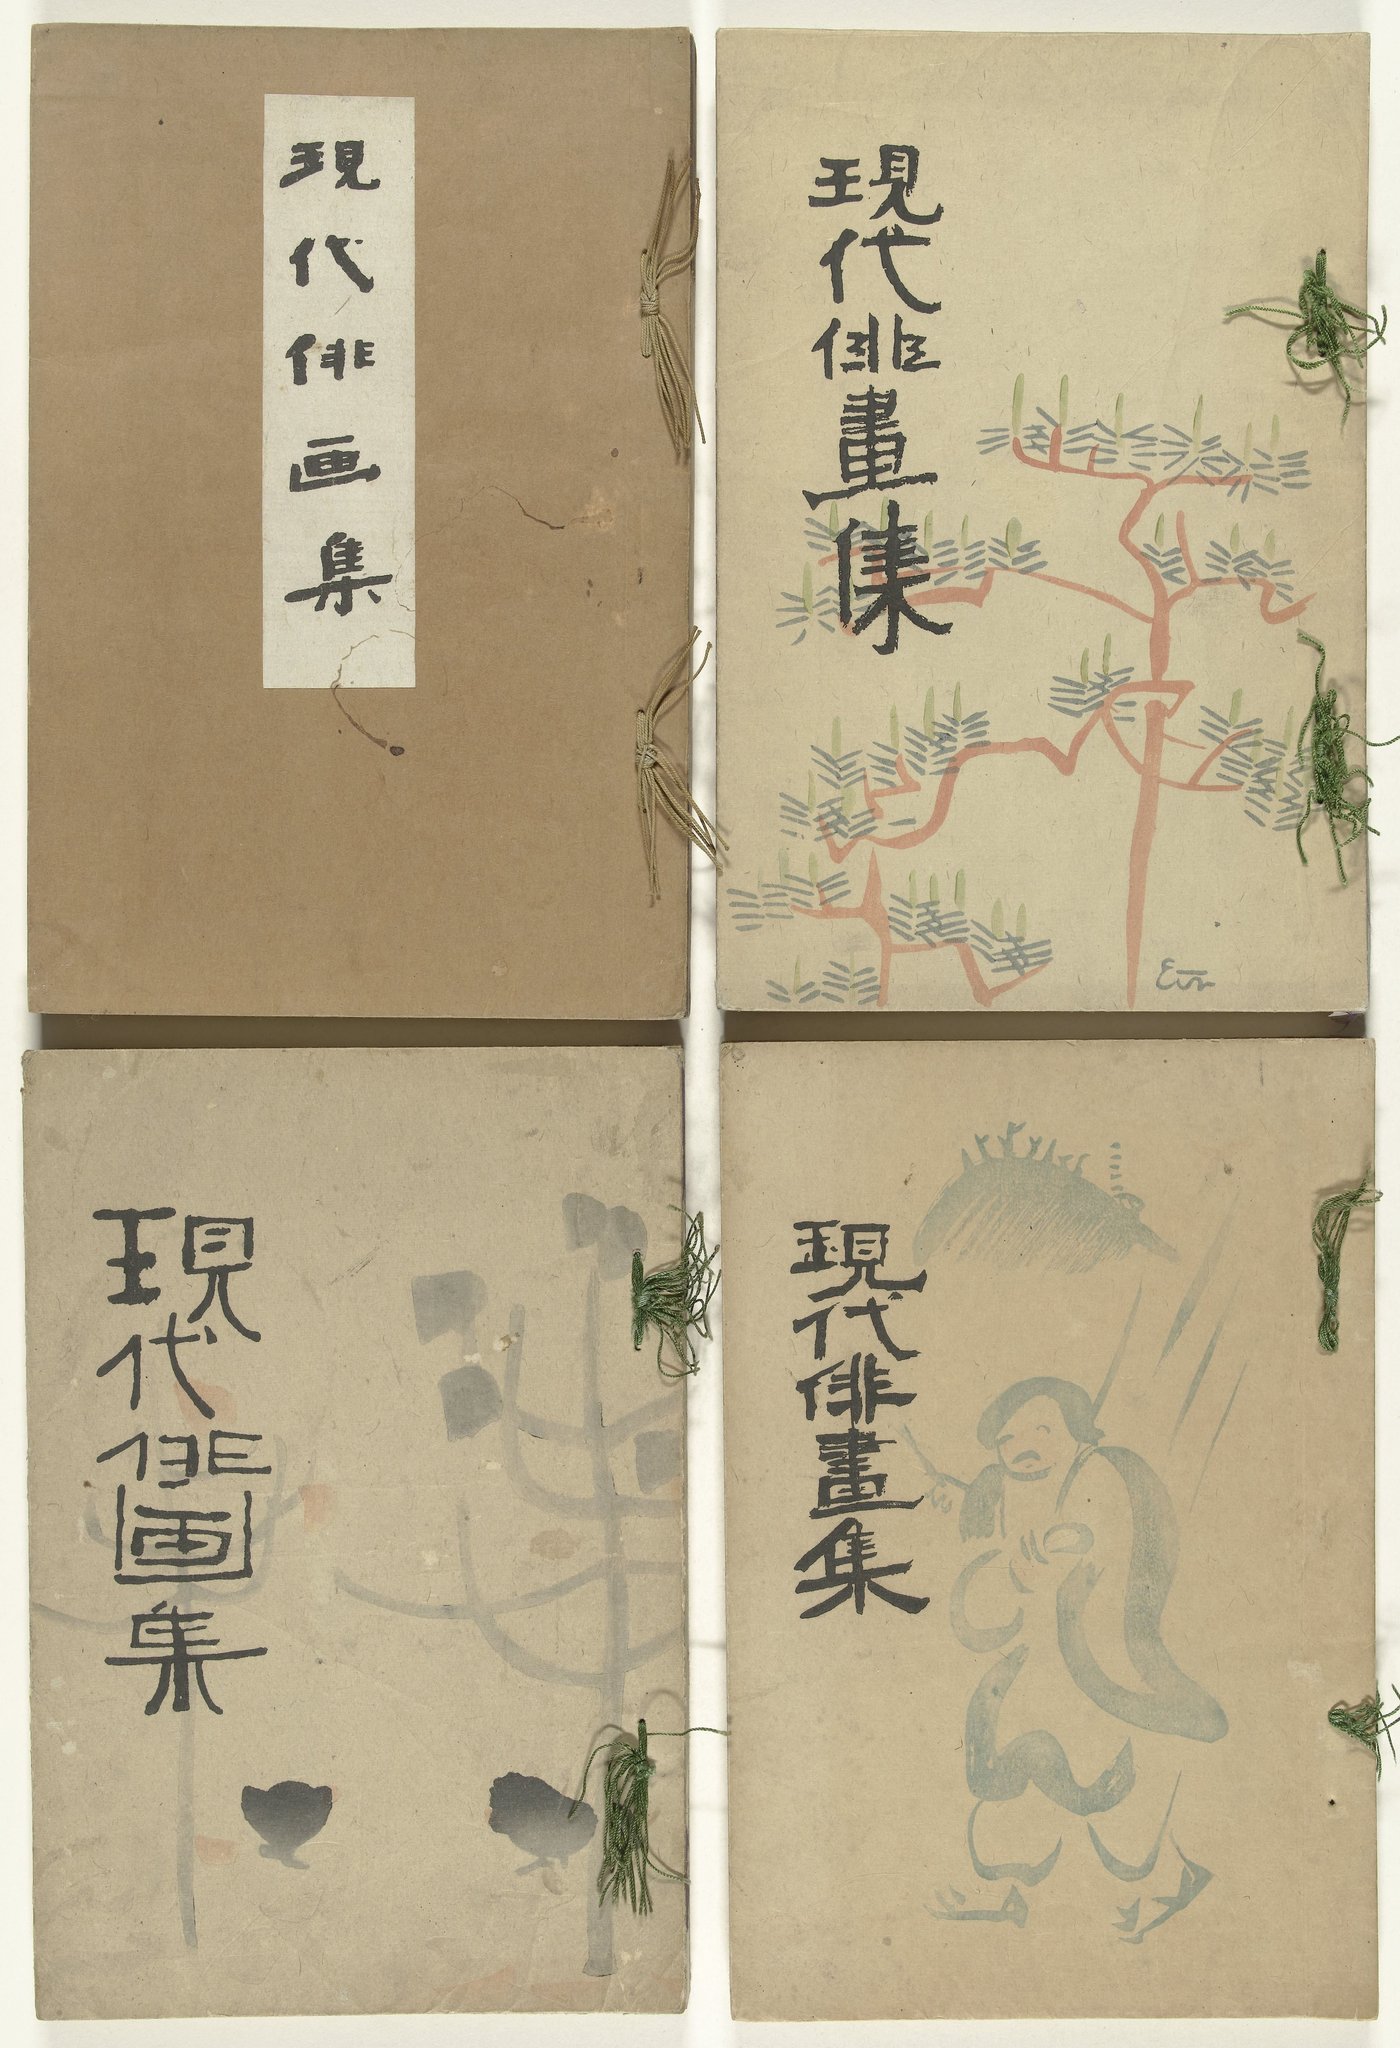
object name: book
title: Gendai haigashu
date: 1915-1917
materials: paper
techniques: woodcut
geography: tokyo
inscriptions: date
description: Vier delen (compleet) met kleurenhoutsneden naar tekeningen in snelle penseelstroken van meer dan 30 kunstenaars. Elk deel verbeeldt één van de vier seizoenen.